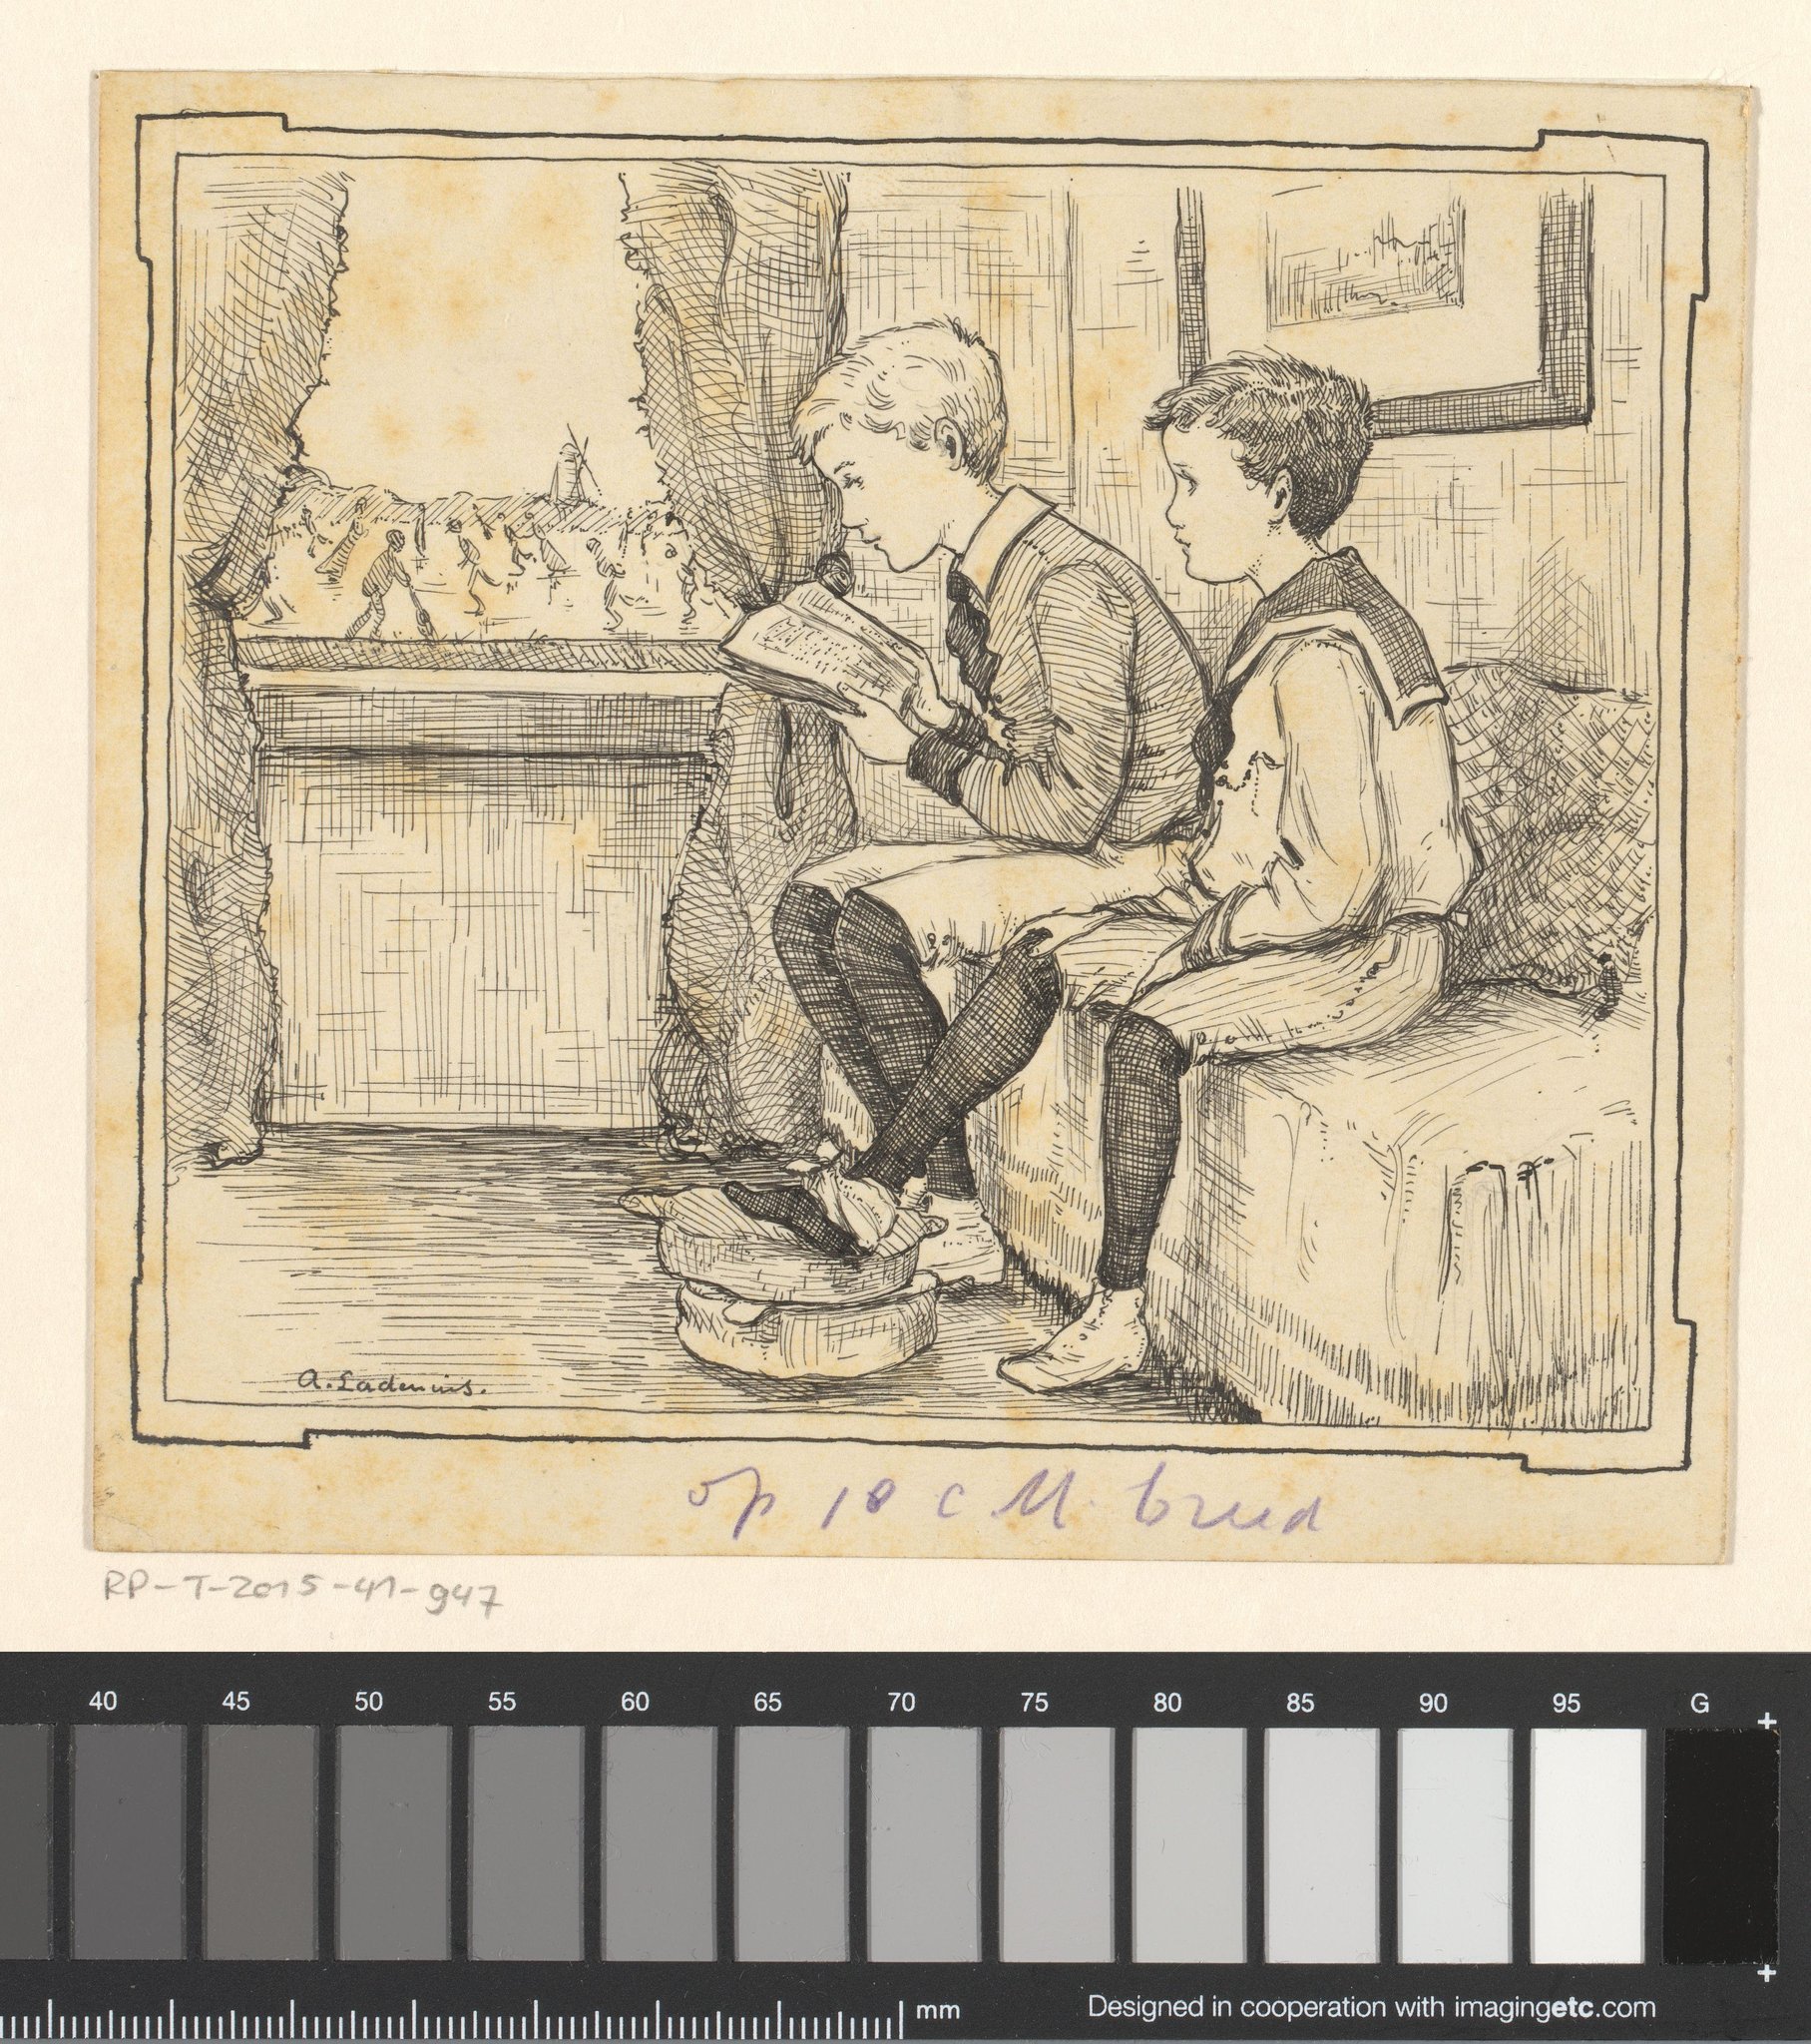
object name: drawing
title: Jongen leest voor op een bank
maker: adri ladenius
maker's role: draughtsman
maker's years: 1883-1953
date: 1893-1953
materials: ink, paper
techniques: pen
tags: reading, skates (winter sports), couch, sofa, settee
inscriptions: :, signature: ‘A. Ladenius.’, collector's mark: Lugt 2228, annotation: ‘2/ En toen las Jan/ Kees wat voor./ 't was een echt gezellige/ middag. (etc-’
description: In een interieur zit een jongen met een boek op de bank. Hij leest een jongen die naast hem zit voor. Door het venster zijn schaatsende mensen op het ijs te zien.